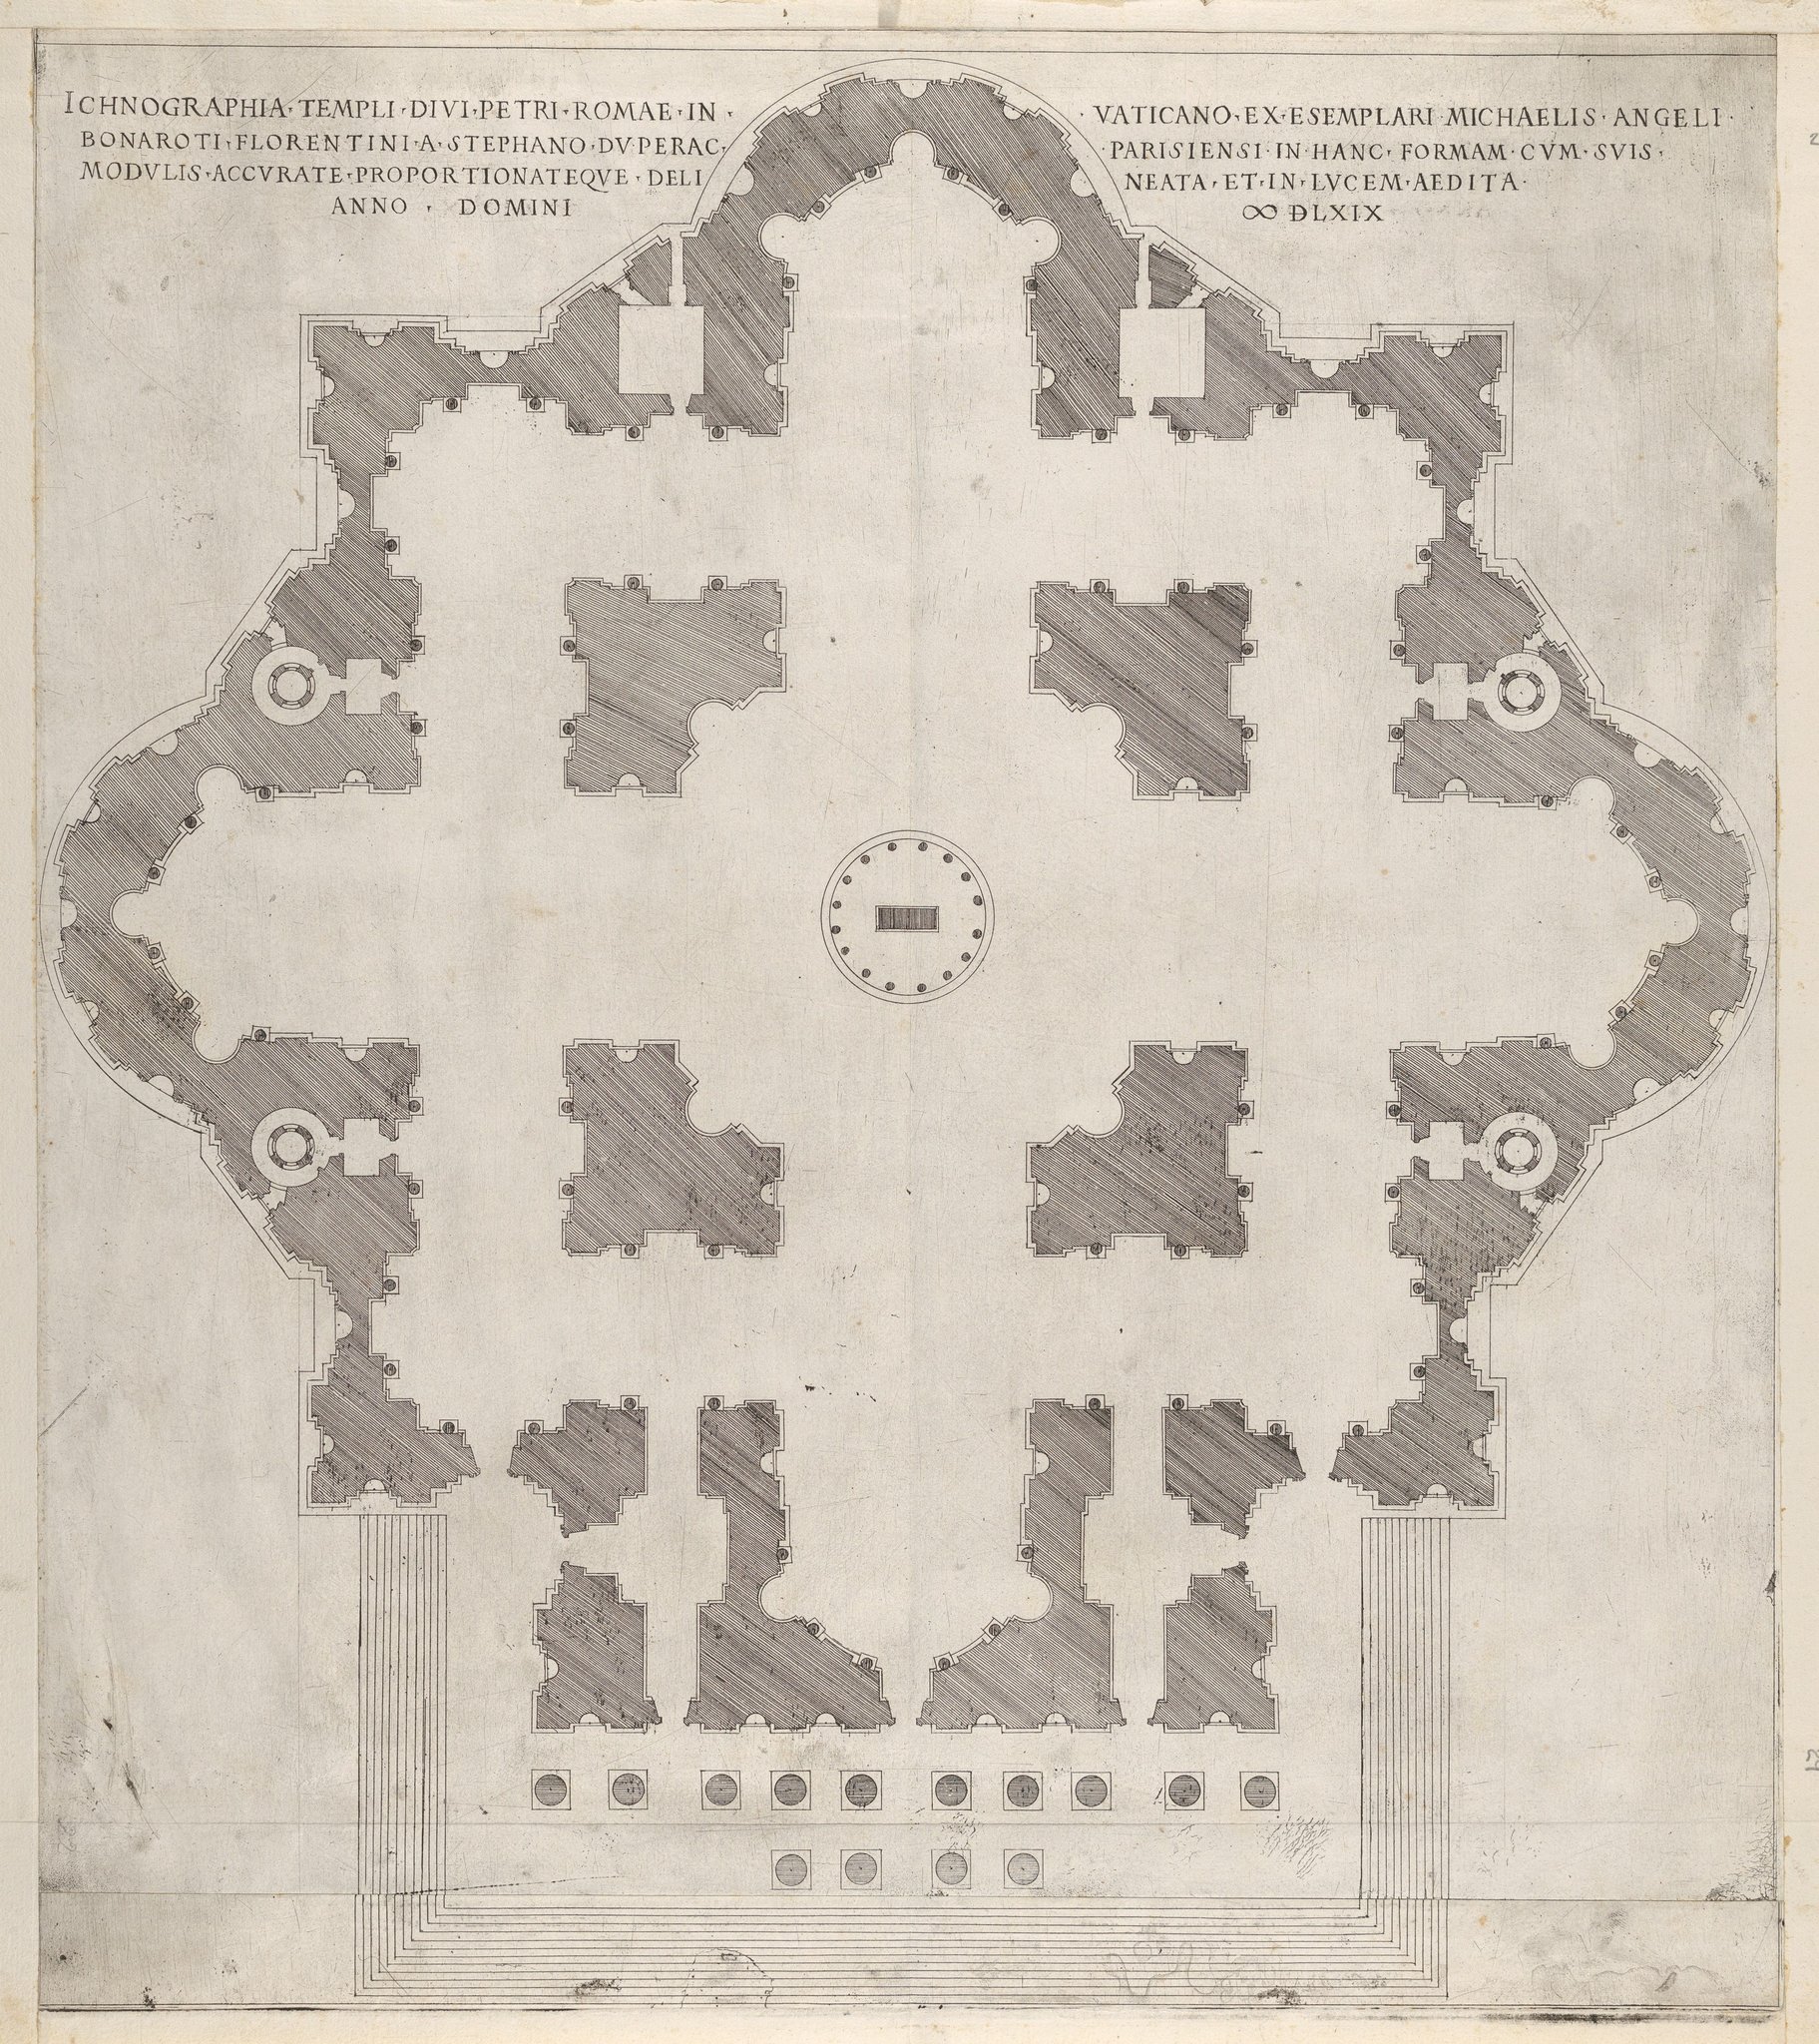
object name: print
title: Plan of St. Peter's, from "Speculum Romanae Magnificentiae"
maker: etienne dupérac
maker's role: artist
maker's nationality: french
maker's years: 1535-1604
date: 1569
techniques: engraving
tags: architecture,rome